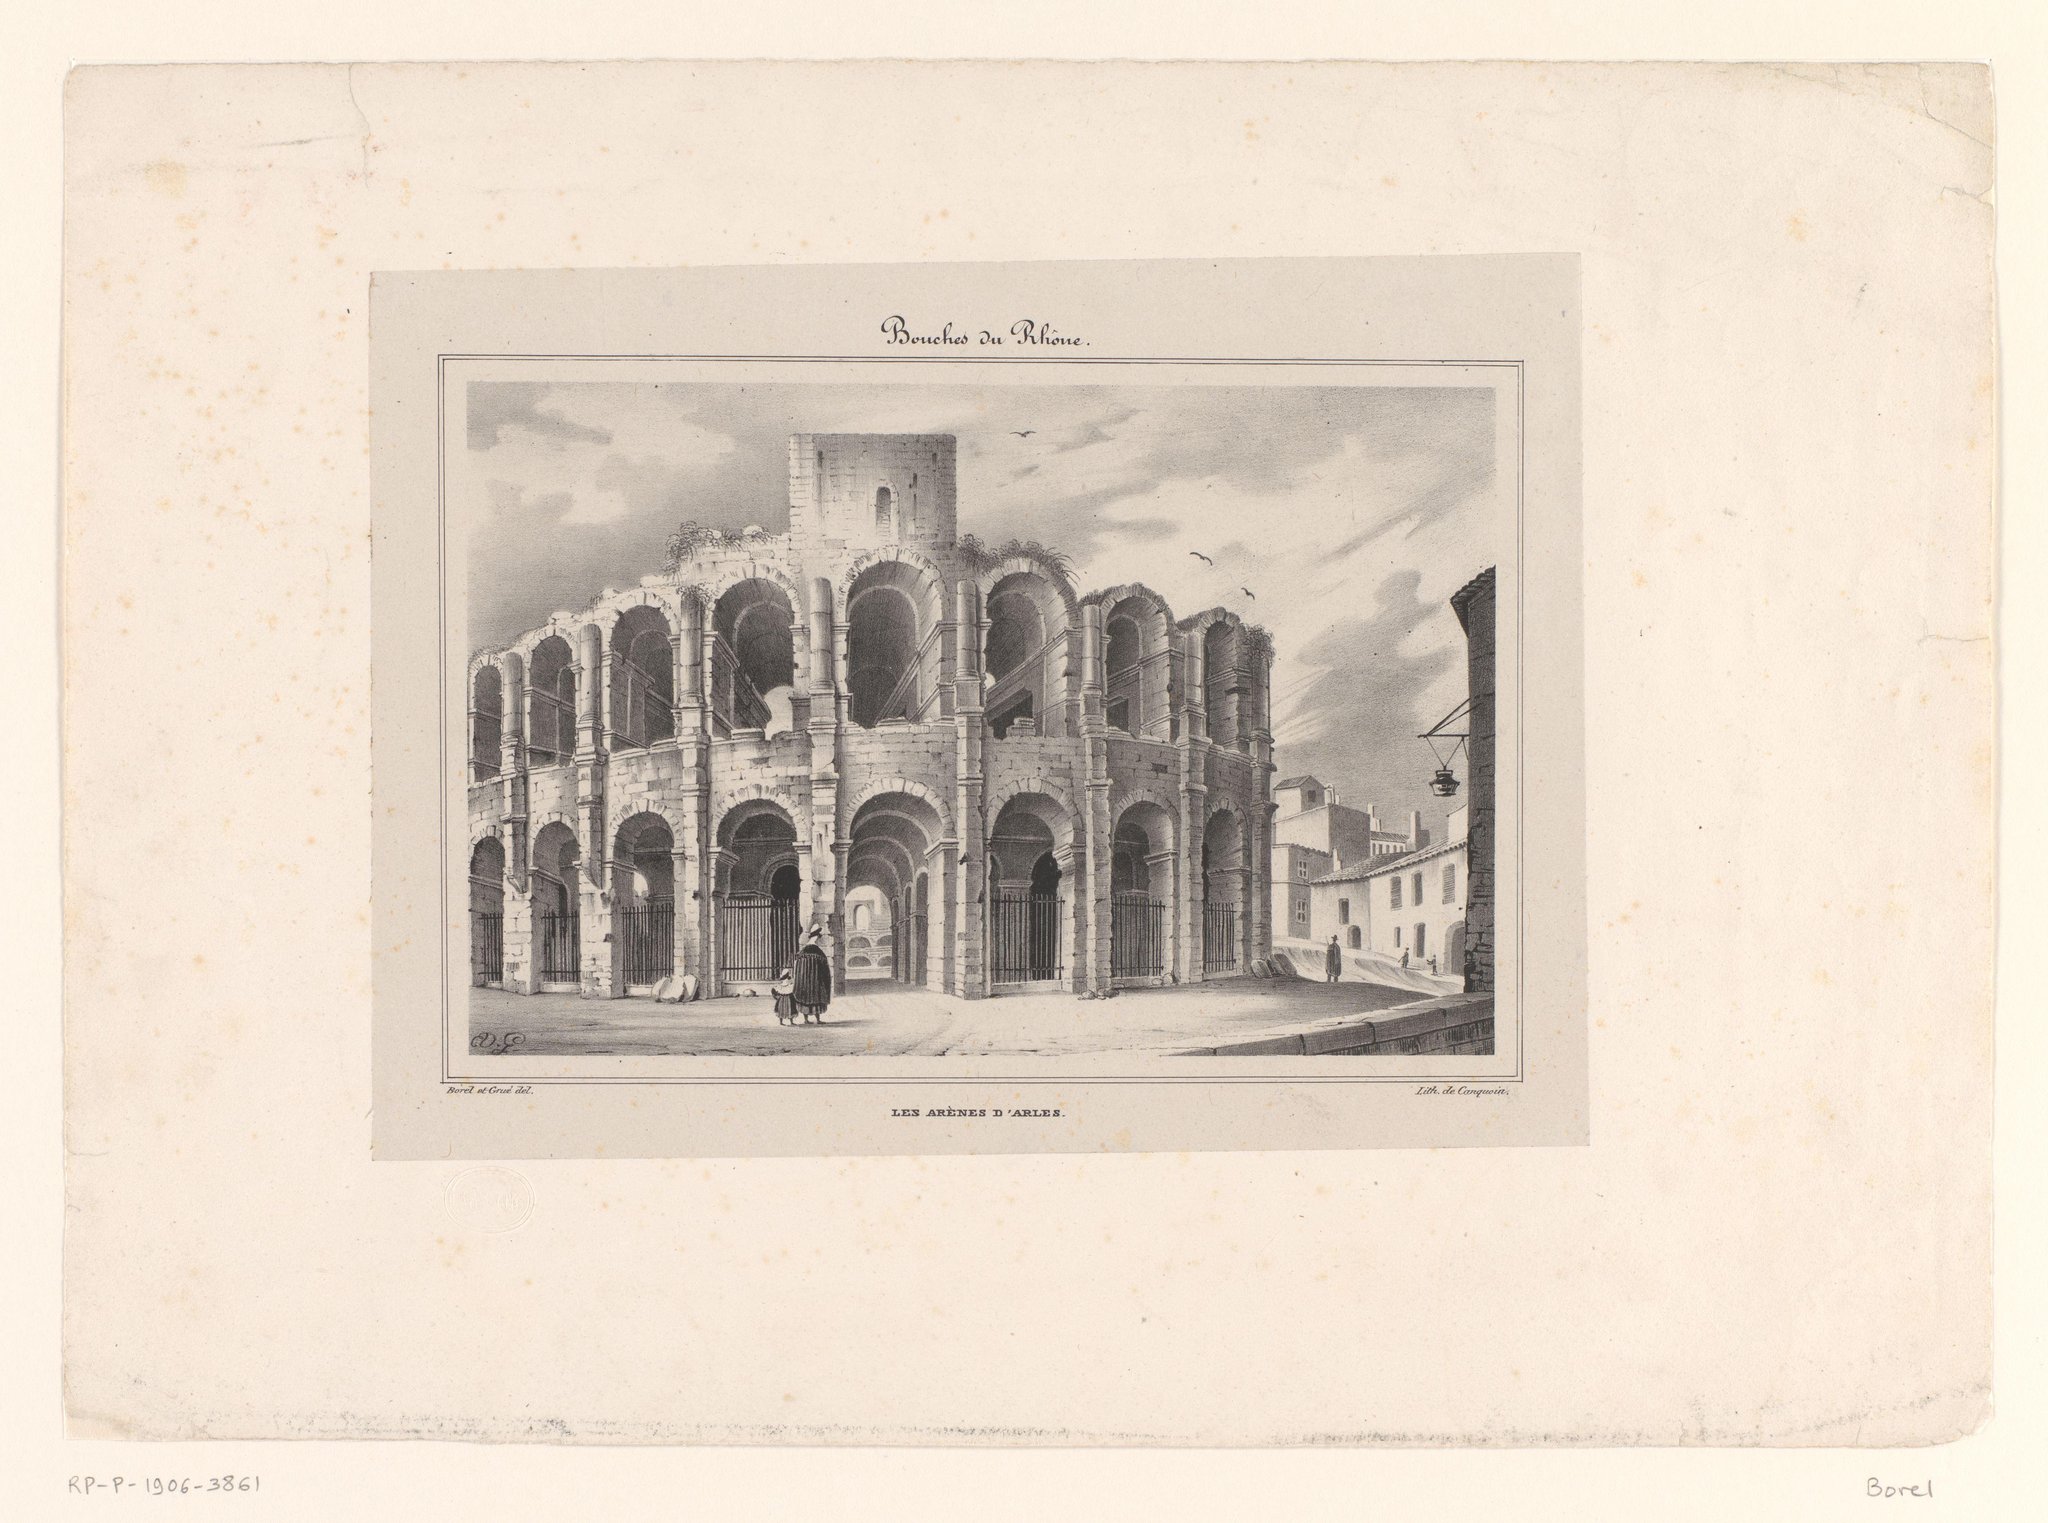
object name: print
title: Les arènes d'Arles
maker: canquoin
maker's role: lithograaf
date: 1832-1833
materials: paper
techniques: lithograph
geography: toulon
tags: ruin of a building ~ architecture, amphitheatre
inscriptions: collector's mark: Lugt 2228a, check stamp: ‘BG’